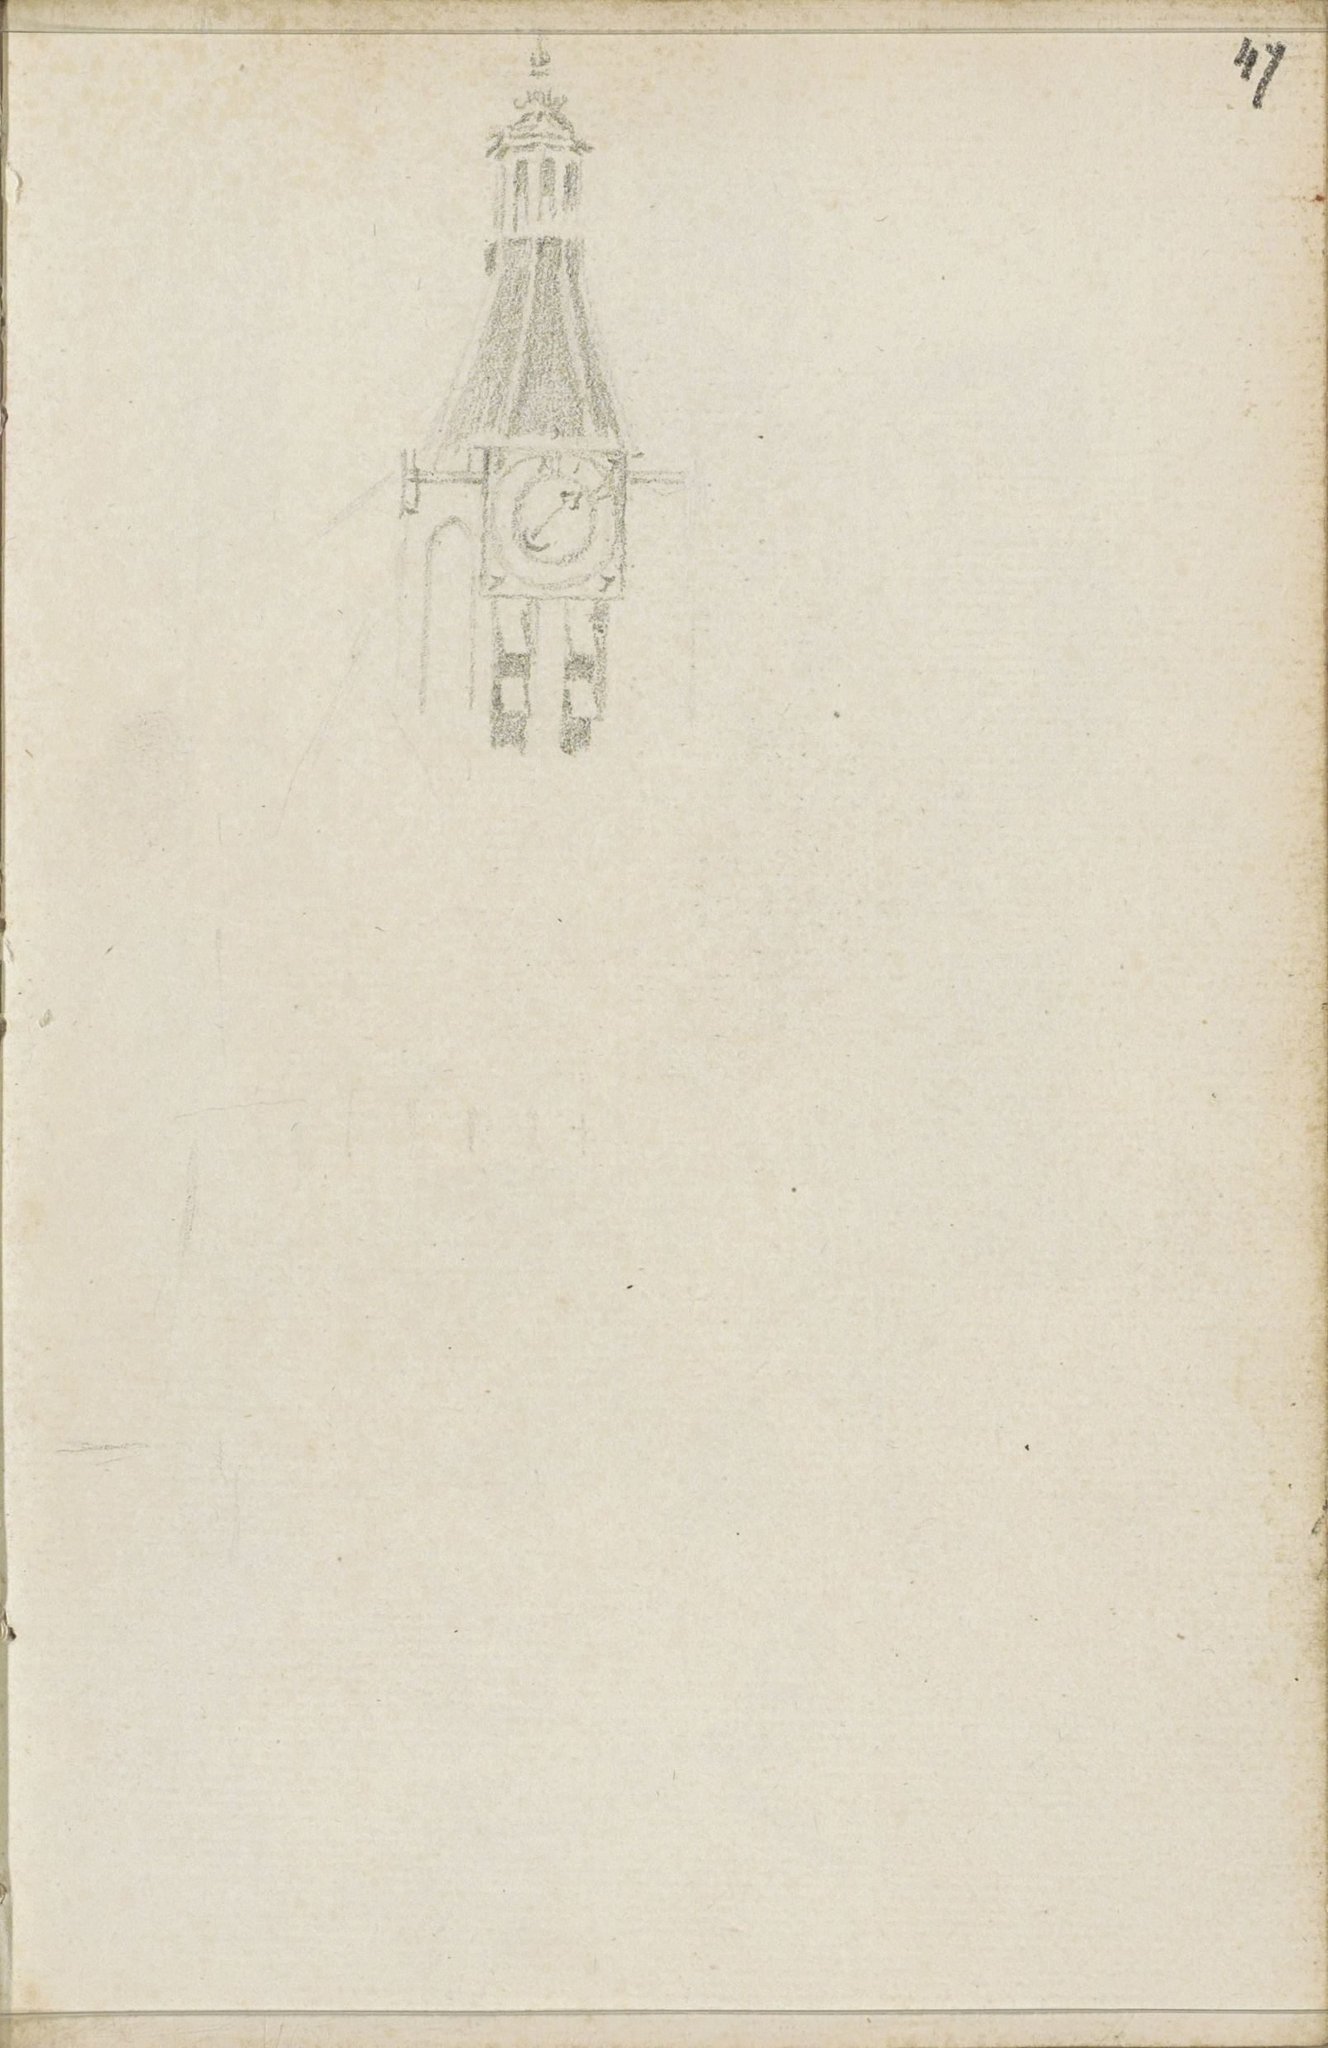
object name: sketchbook leaf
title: Kerktoren met een klok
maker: jacob perkois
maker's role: draughtsman, print maker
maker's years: 1756-1804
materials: paper, pencil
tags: tower, clock tower ~ monumental adornment, parts of church exterior and annexes: tower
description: Bladzijde 47 uit een schetsboek met 78 bladzijden.